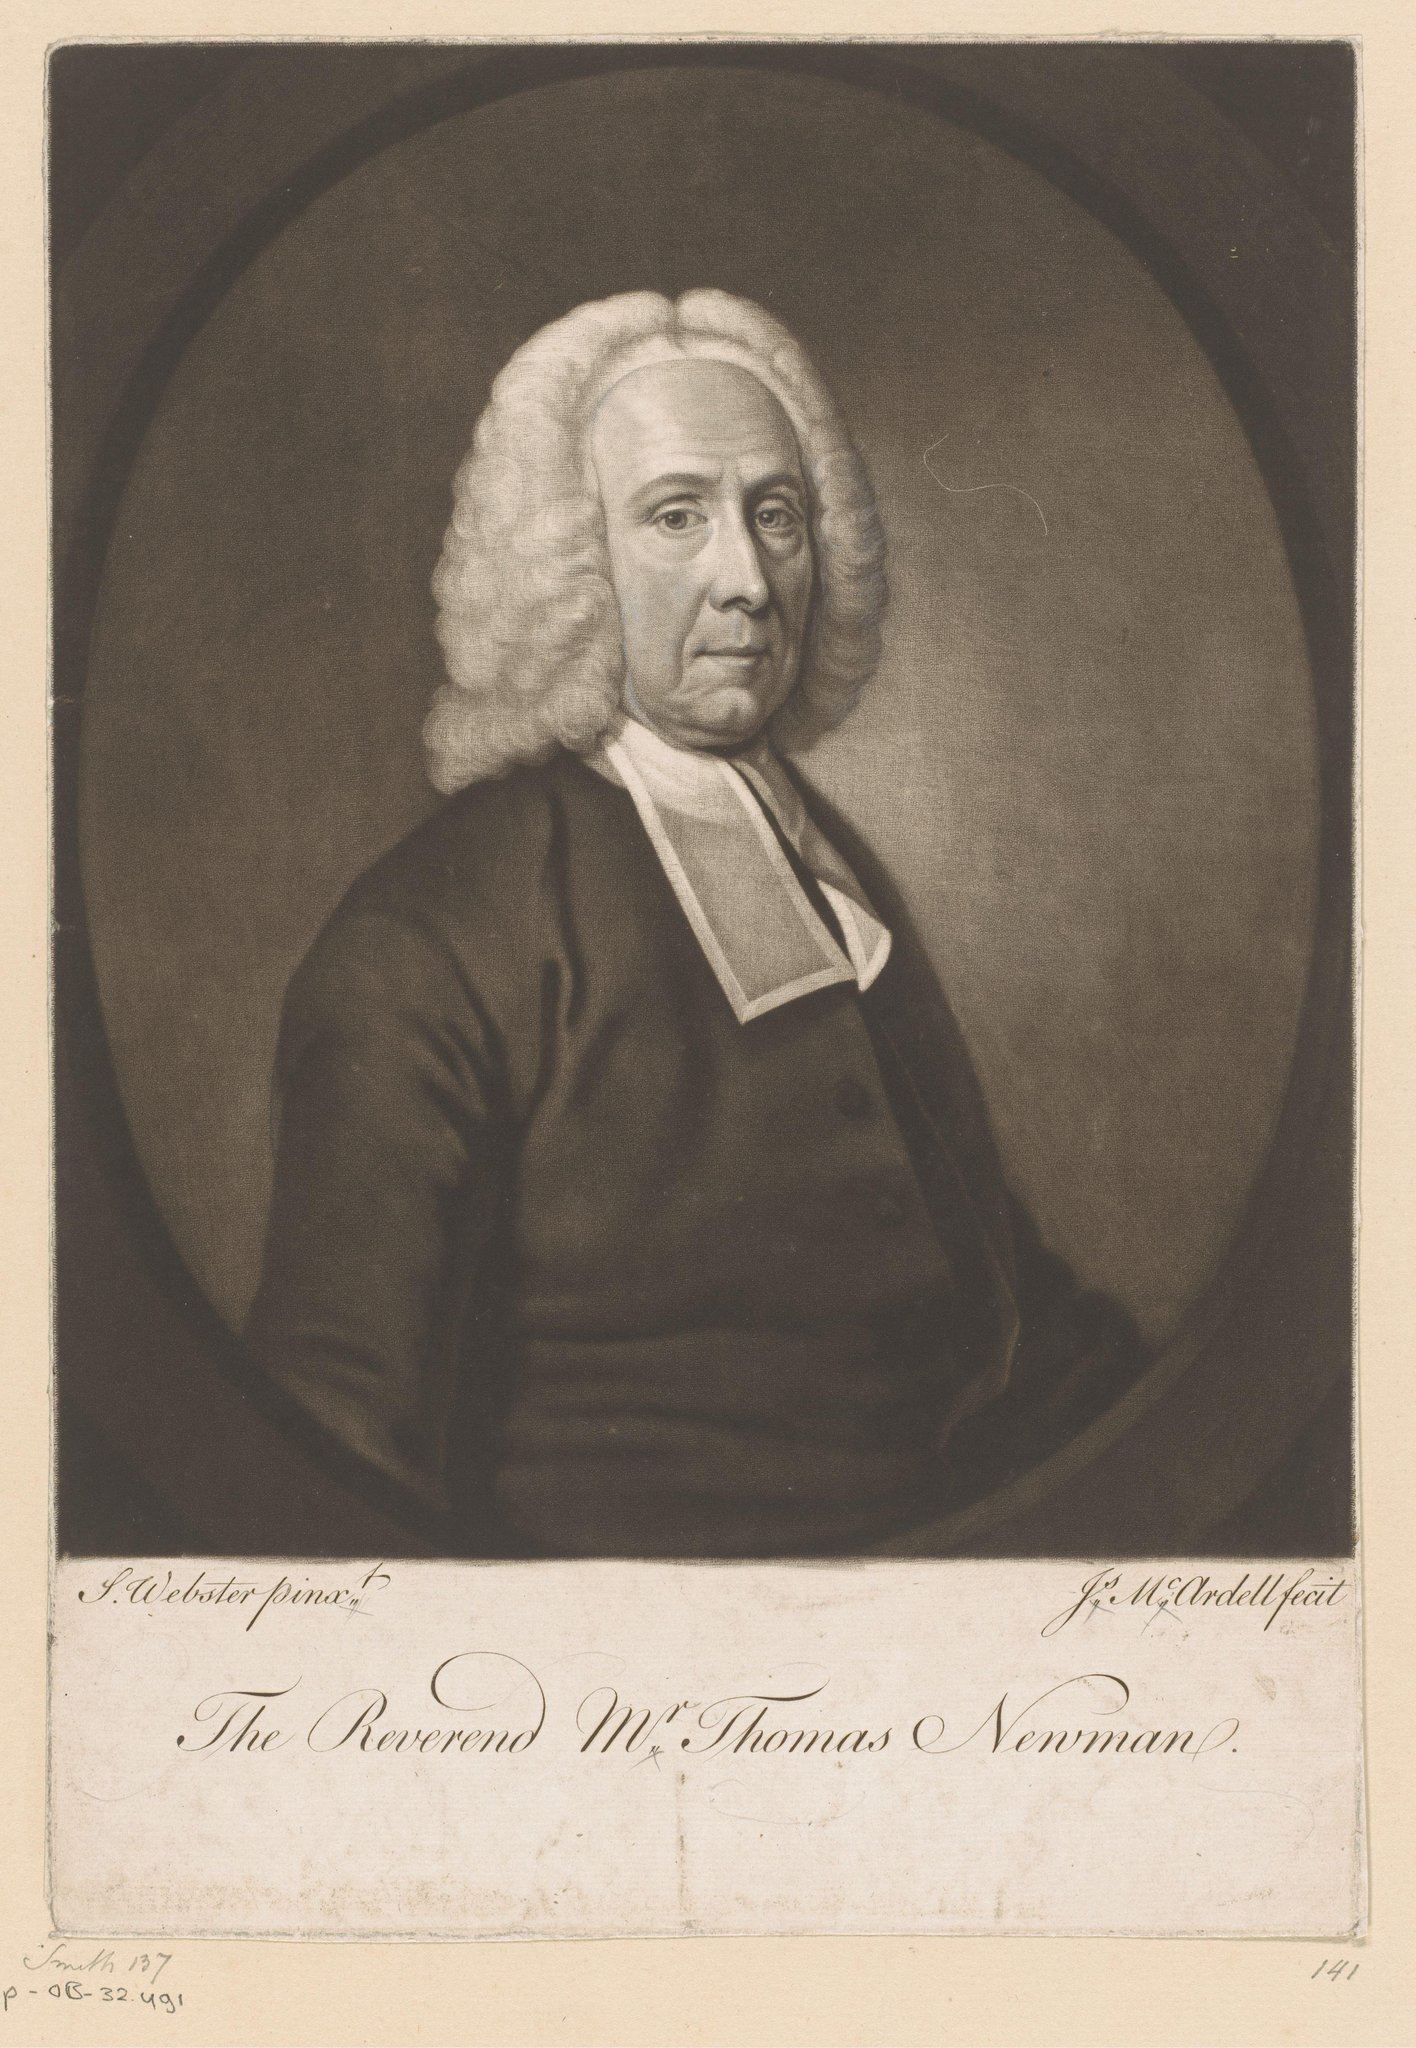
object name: print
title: The Reverend Mr. Thomas Newman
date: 1745-1765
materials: paint, paper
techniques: brush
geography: london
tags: clergyman, historical persons, functionaries and dignitaries (with name) ~ protestant churches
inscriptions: collector's mark: Lugt 240